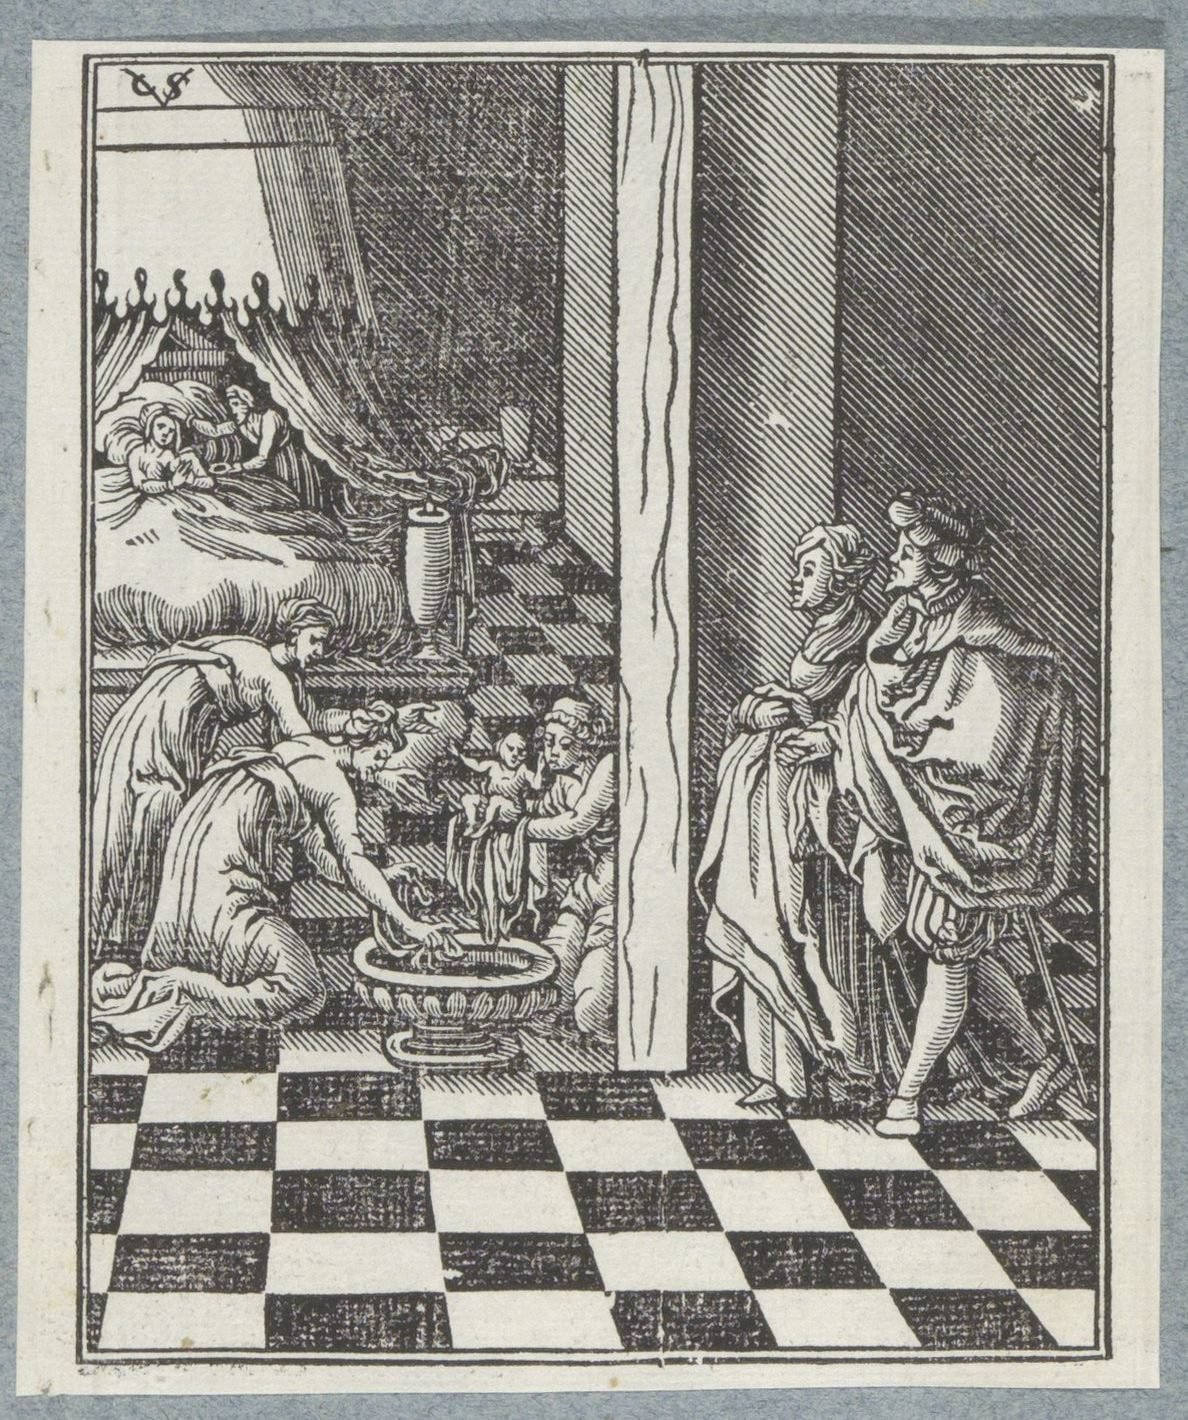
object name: print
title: Geboorte van Johannes de Doper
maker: pieter jacobsz. paets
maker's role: publisher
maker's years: 1587-1667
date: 1645-1646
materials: paper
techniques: woodcut, pasting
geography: amsterdam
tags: birth of john the baptist, sometimes mary present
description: De prent werd gemaakt voor de uitgaven van P.J. Paets uit Amsterdam. Ze komt in ieder geval voor in: Bibels Tresoor ofte der zielen lusthof. Amsterdam, P.J. Paets, 1646. Mogelijk ook in: Historien ende Prophetien. [Amsterdam], P.J. Paets, 1645.